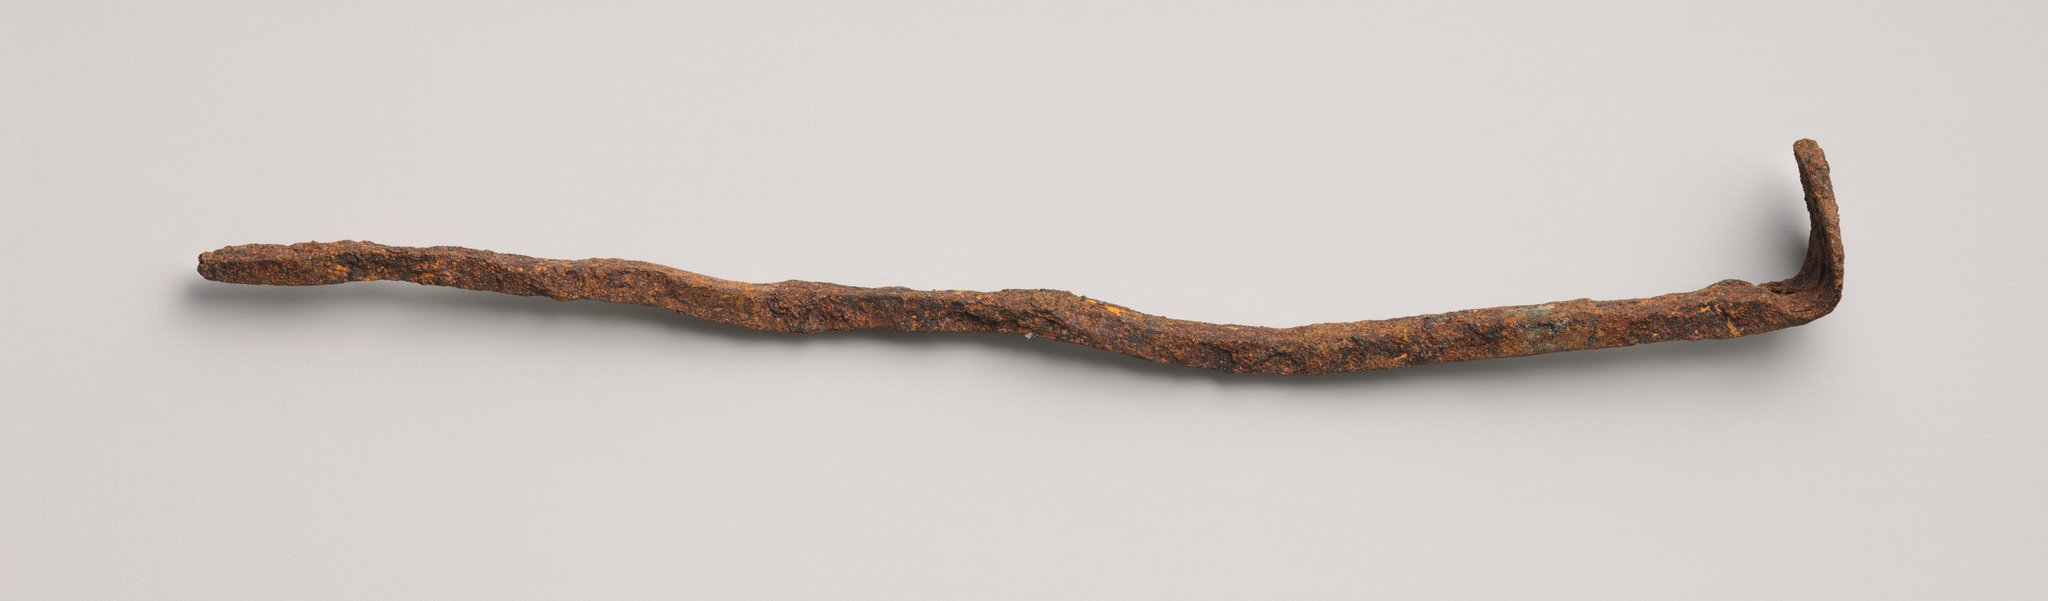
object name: key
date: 306-30 BCE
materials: iron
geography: egypt